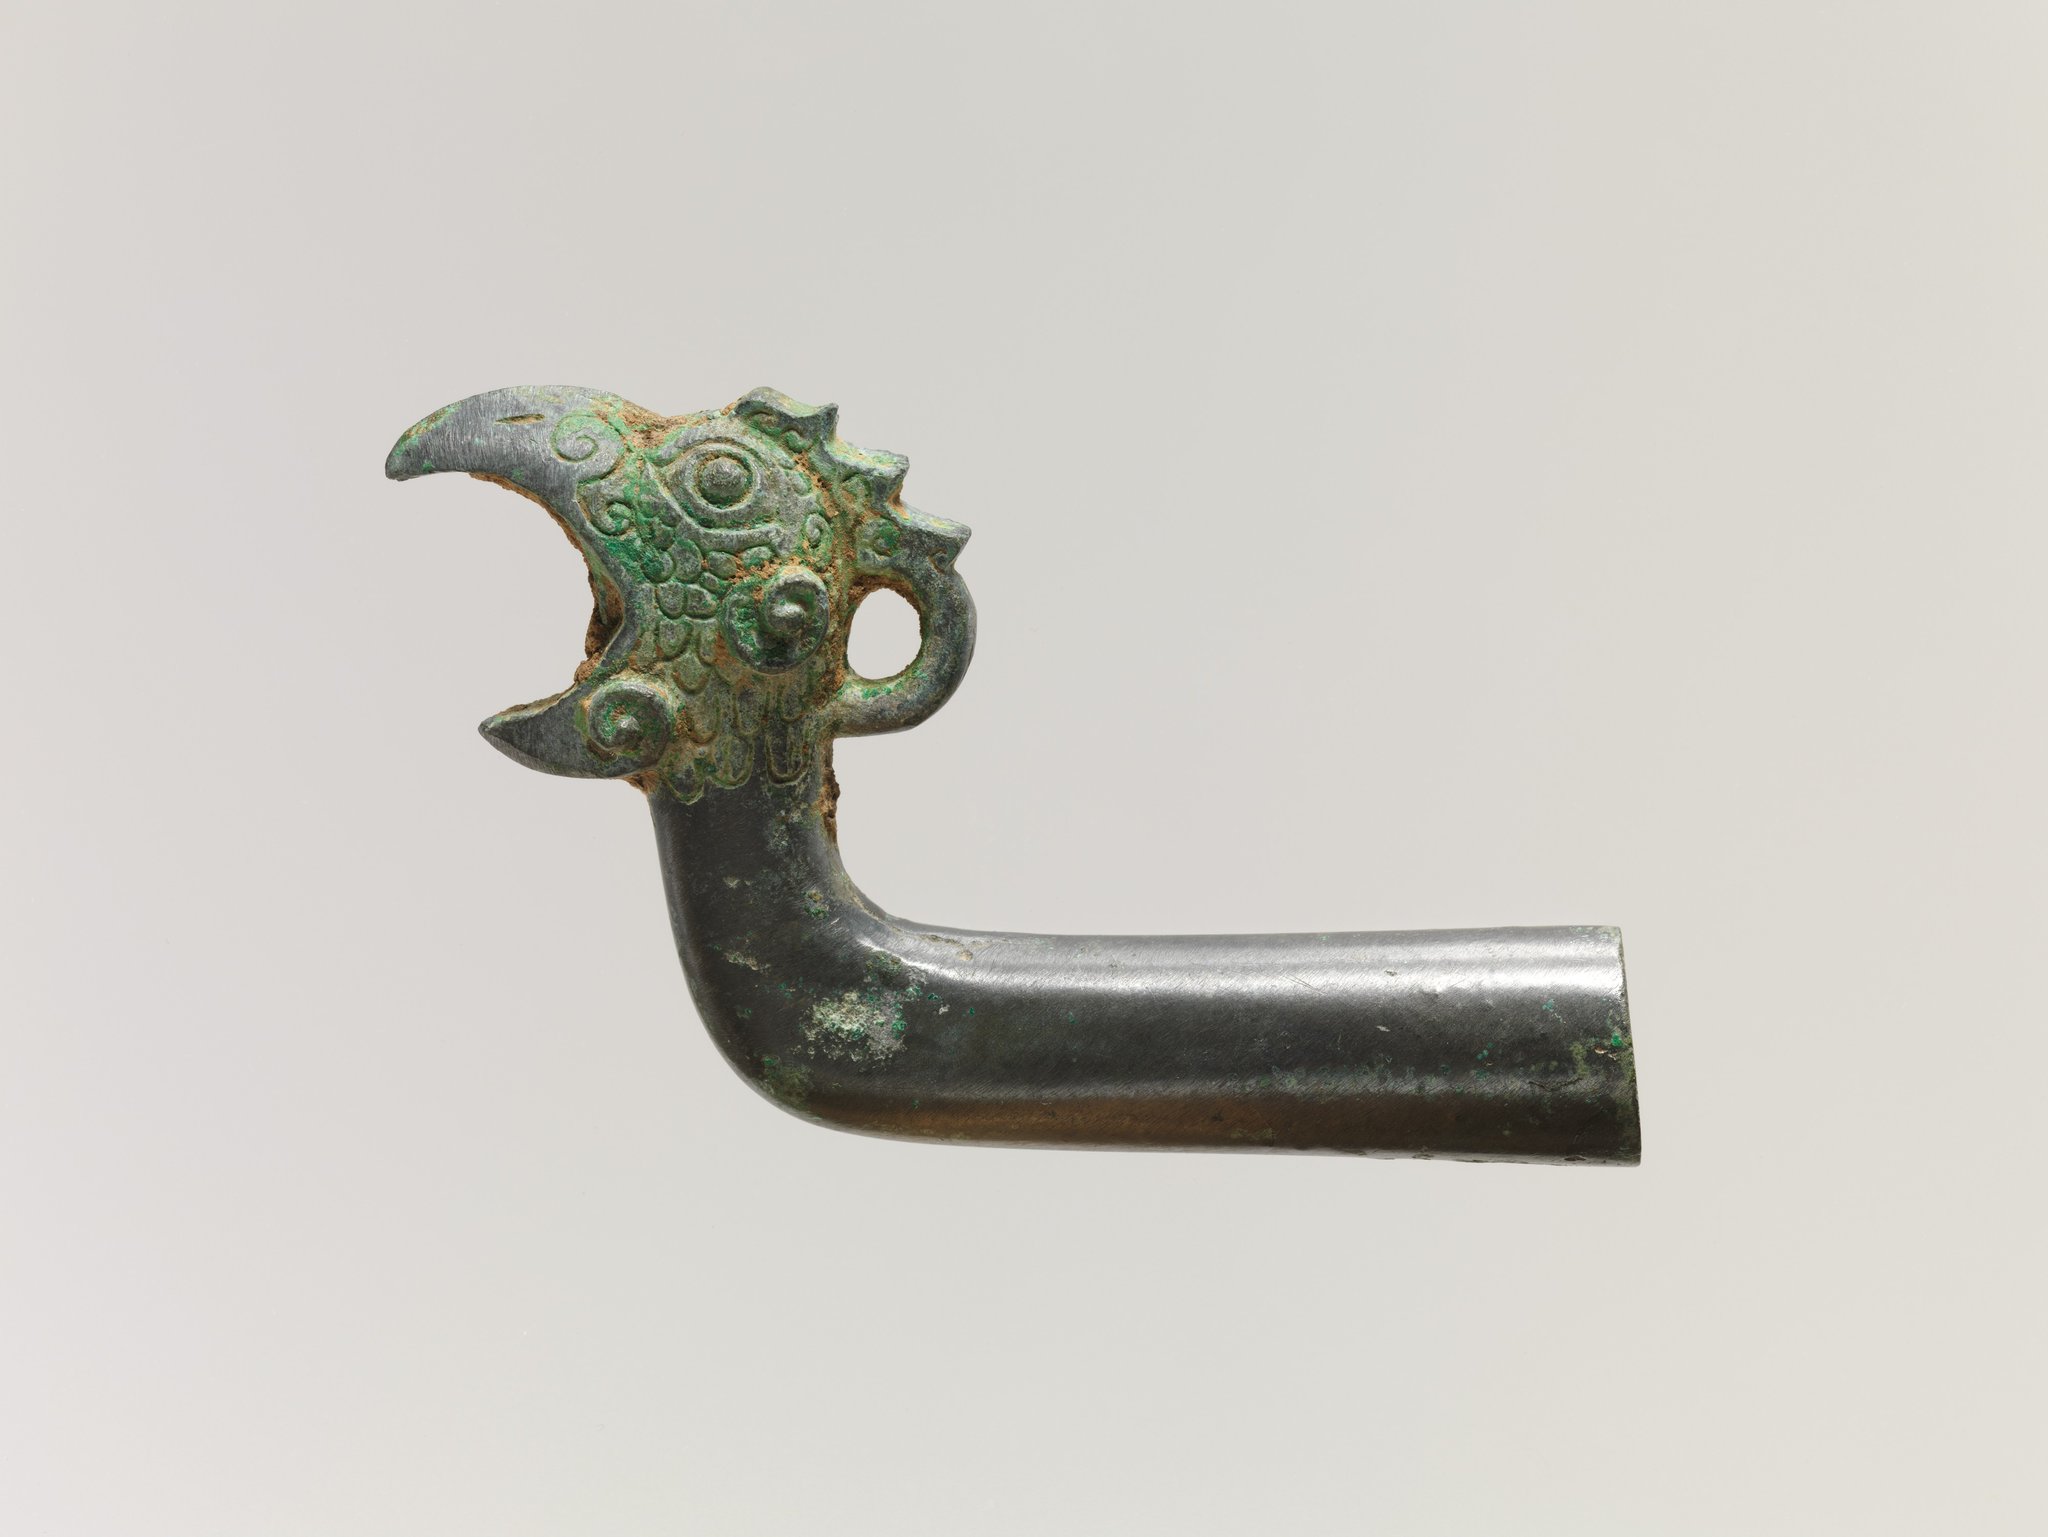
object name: finial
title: Bird-head finial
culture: chinese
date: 500-201 BCE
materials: bronze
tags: birds